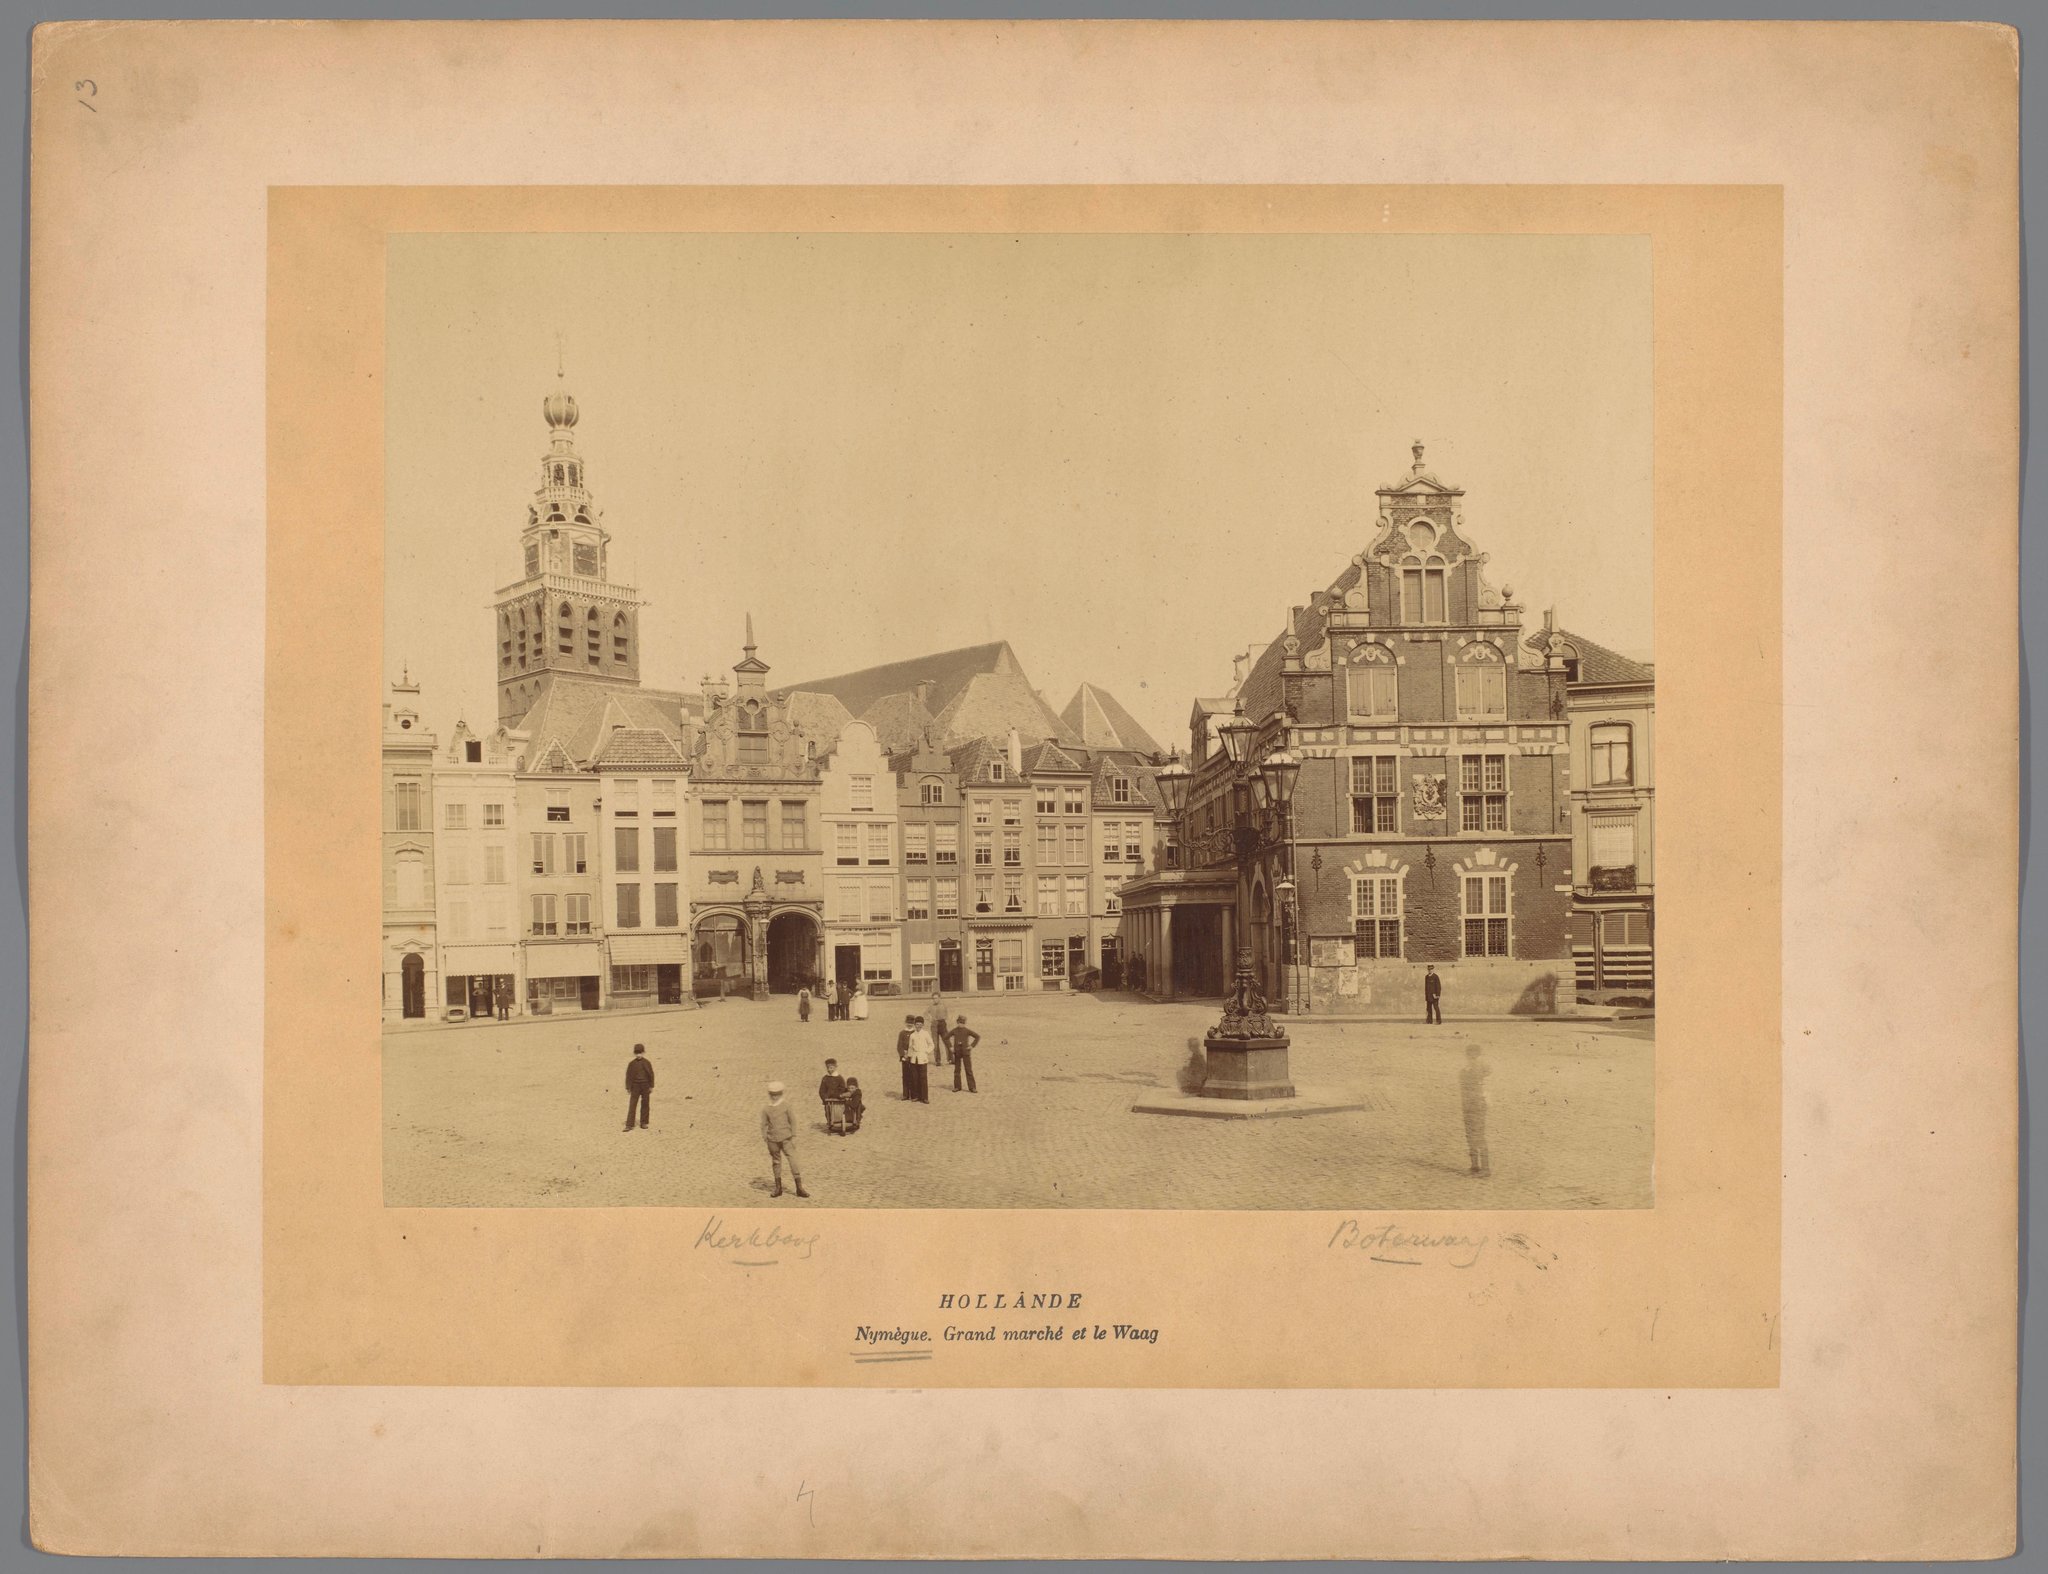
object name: photograph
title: Gezicht op de Grote Markt en de Boterwaag te Nijmegen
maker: Anonymous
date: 1875-1900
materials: cardboard, photographic support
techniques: albumen print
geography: grote markt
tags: façade (of house or building), weigh-house, village square, place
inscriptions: inscription: ‘B.F.K. Rives No 74’, inscription: ‘HOLLANDE Nymègue. Grand marché et le Waag’, collector's mark: Lugt 3937, inscription: ‘Kerkboog Boterwaag’